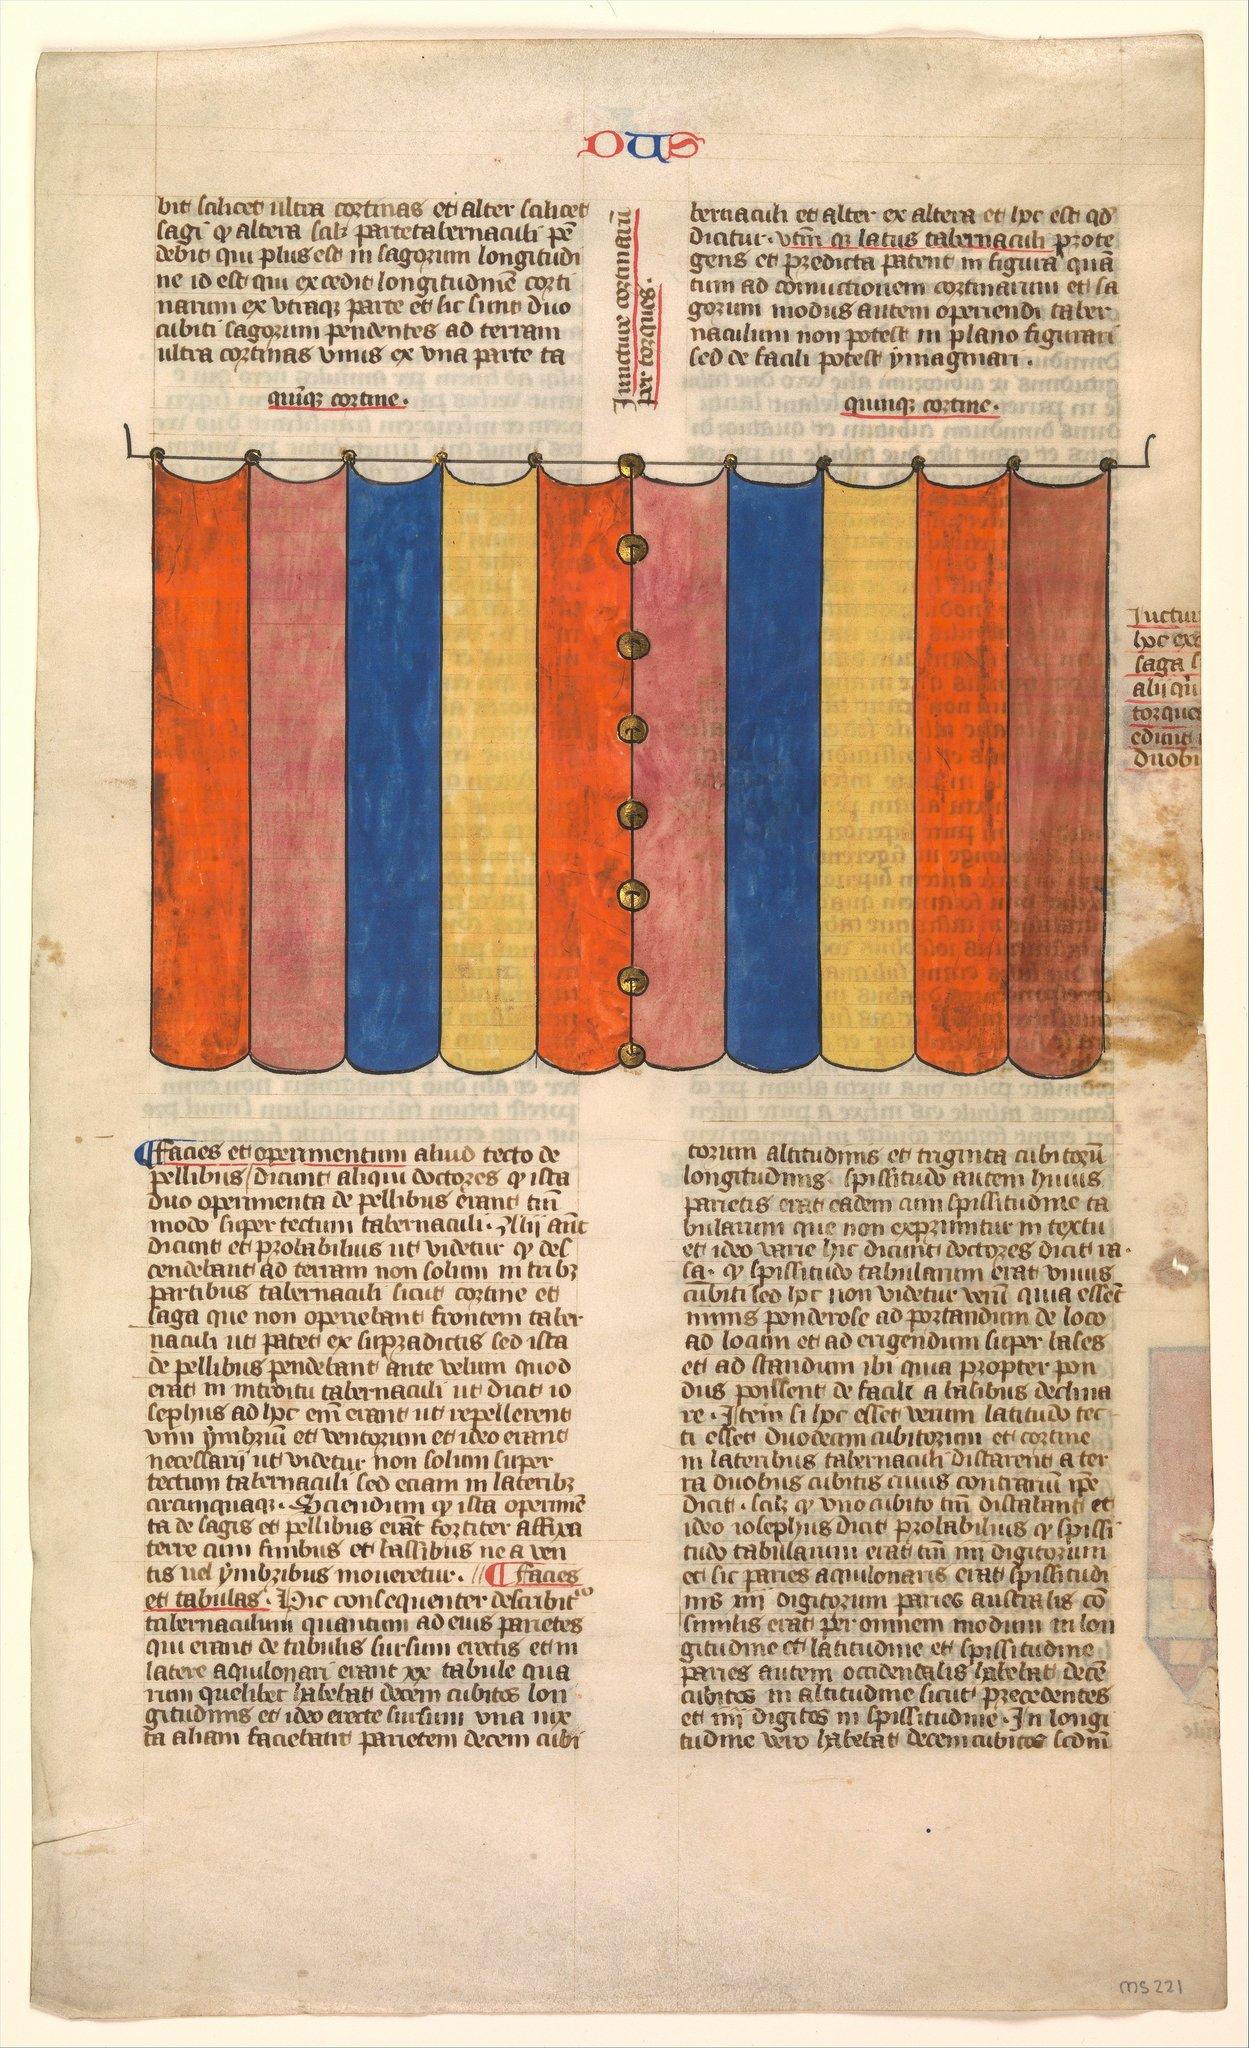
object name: manuscript leaf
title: Curtain of the Tabernacle, one of six illustrated leaves from the Postilla Litteralis (Literal Commentary) of Nicholas of Lyra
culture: french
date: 1360-1380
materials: gold, ink, iron, parchment, watercolor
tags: curtains